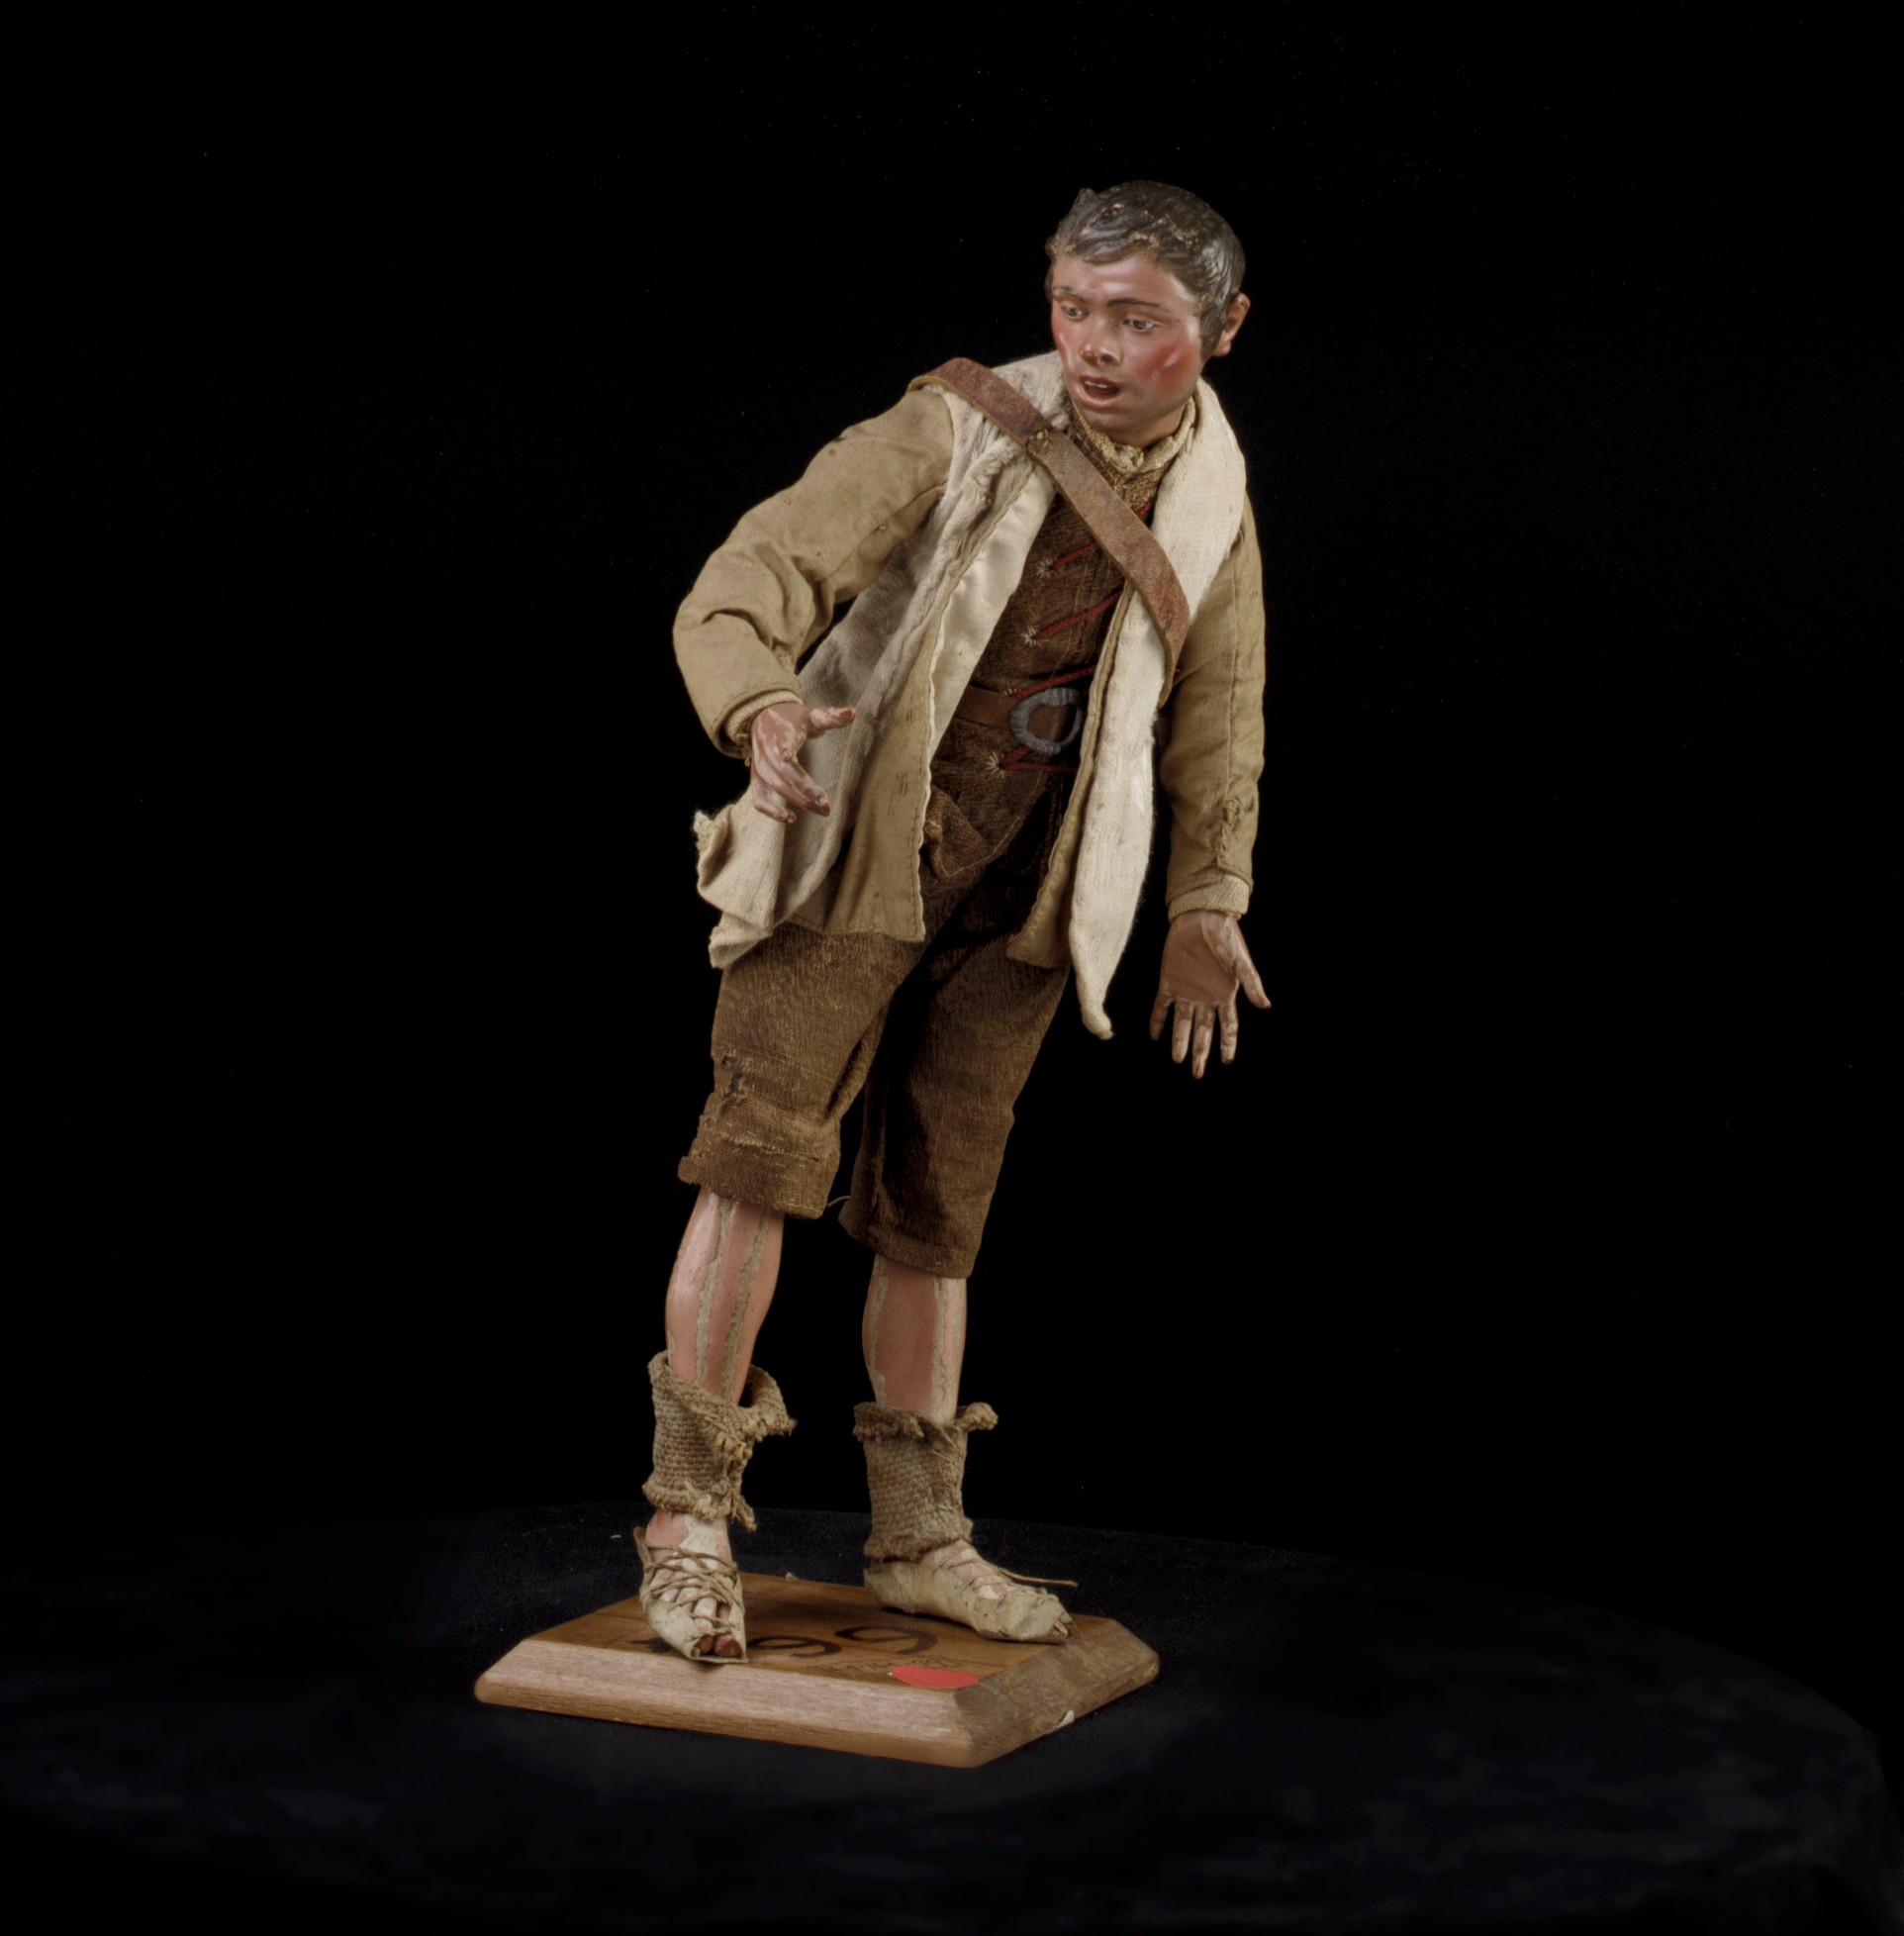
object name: crèche figure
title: Shepherd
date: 1751-1800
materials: cotton, leather, terracotta, fiber, metal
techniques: polychrome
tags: men,shepherds